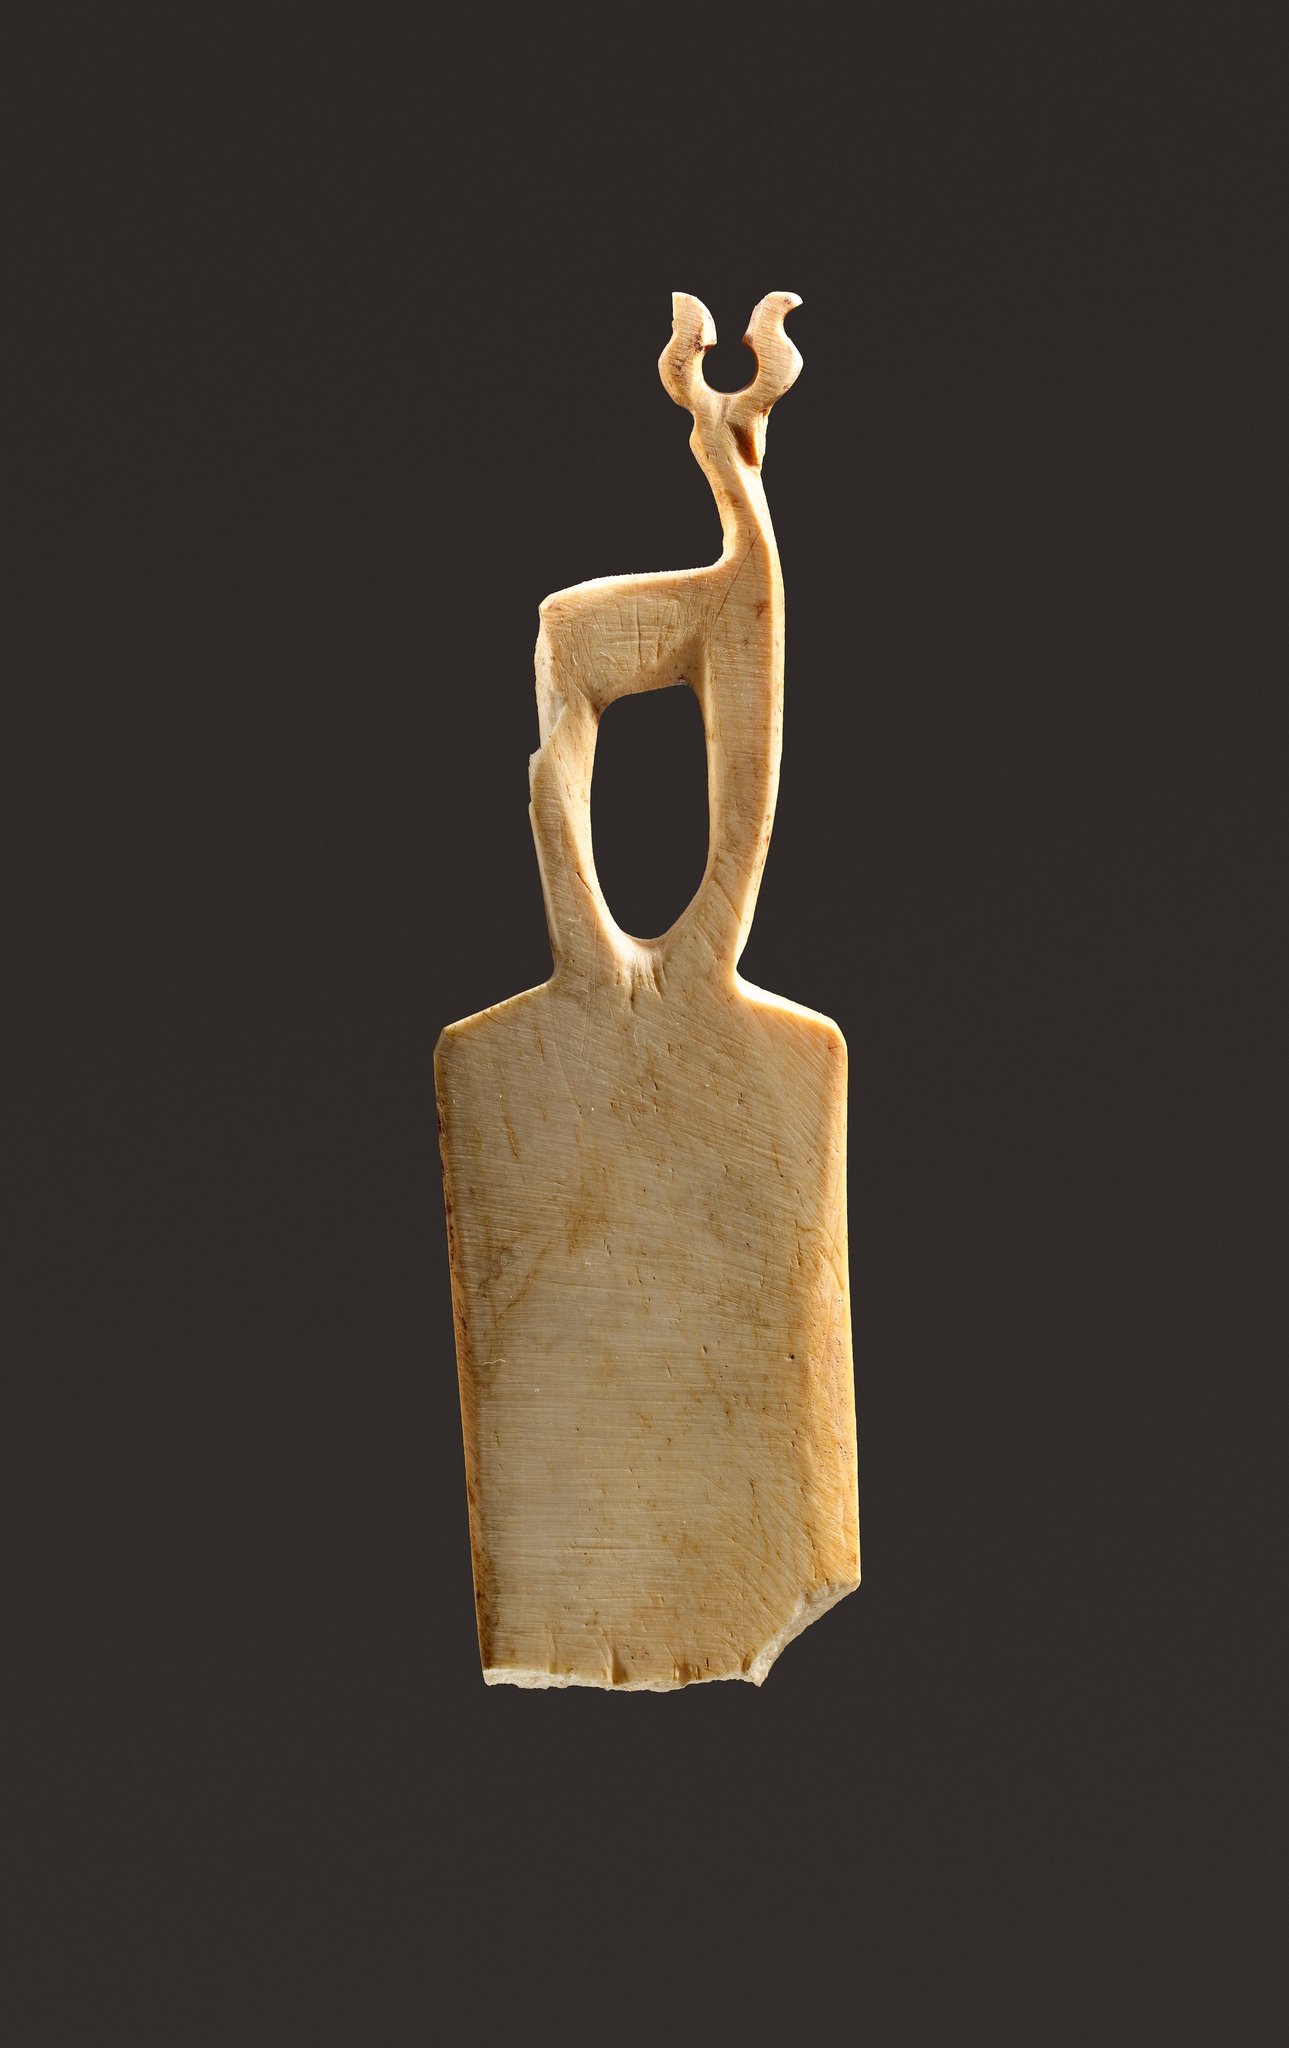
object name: comb, antelope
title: Bone comb with an antelope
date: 3900-3500 BCE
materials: bone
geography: egypt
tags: animals